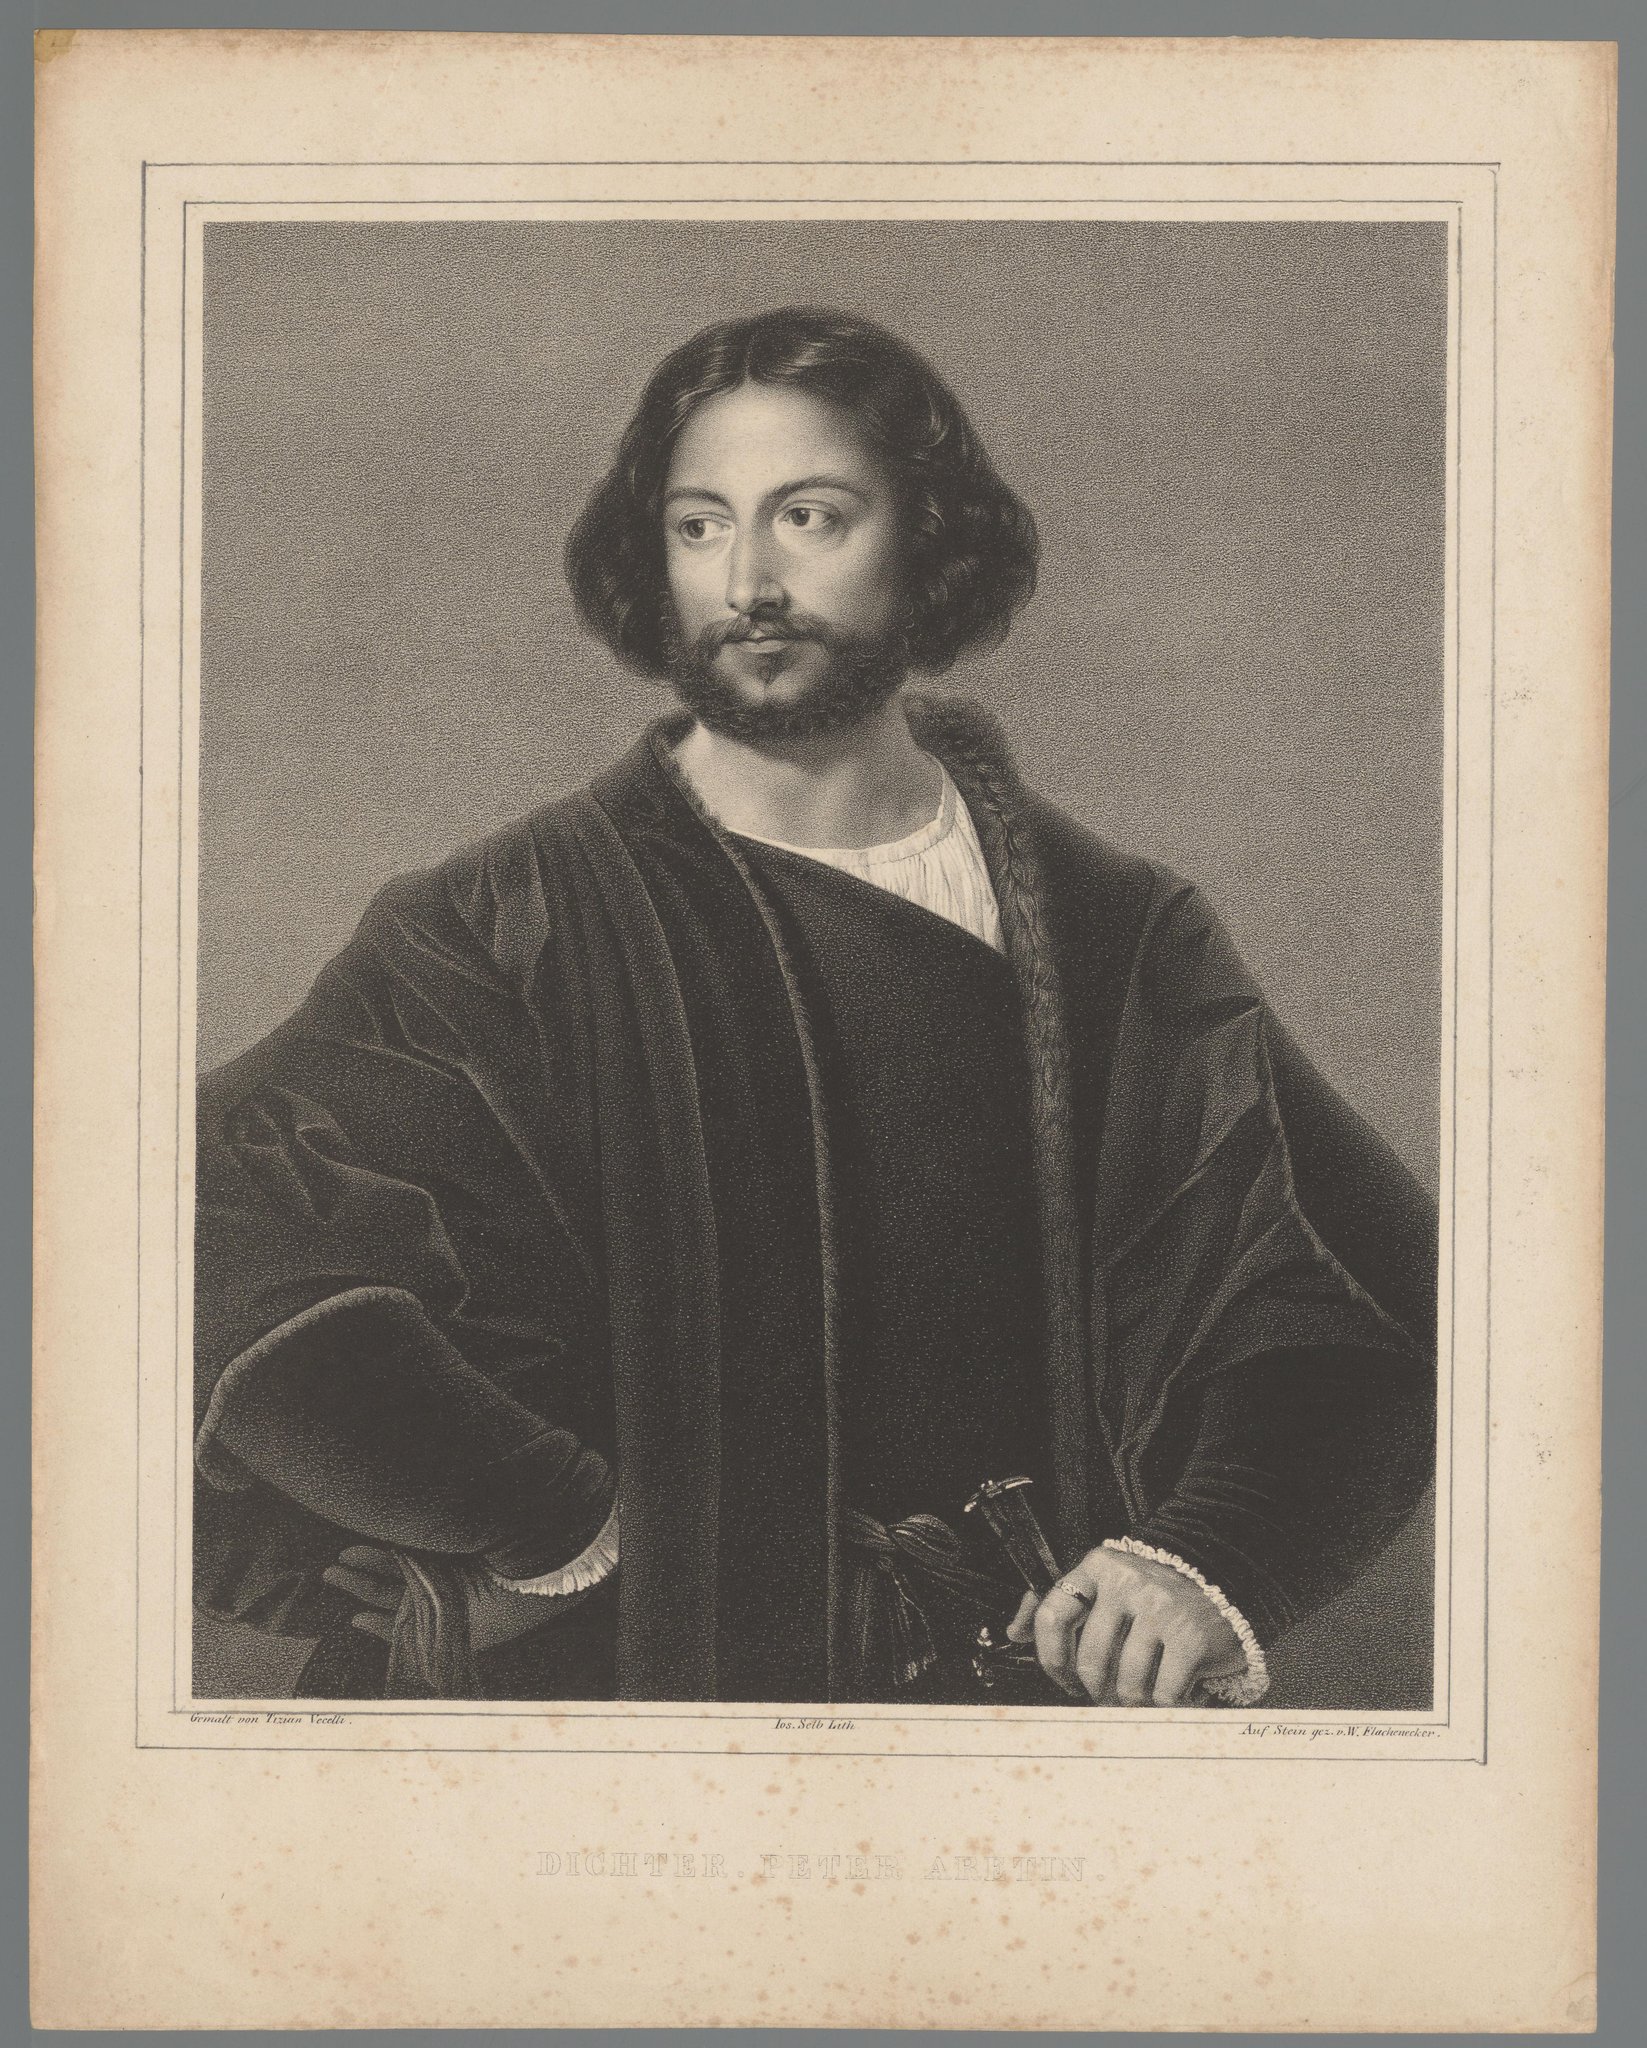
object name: print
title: Portret van Pietro Aretino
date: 1820-1832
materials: paper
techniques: lithograph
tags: historical persons, writer, poet, author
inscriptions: collector's mark: Lugt 2228